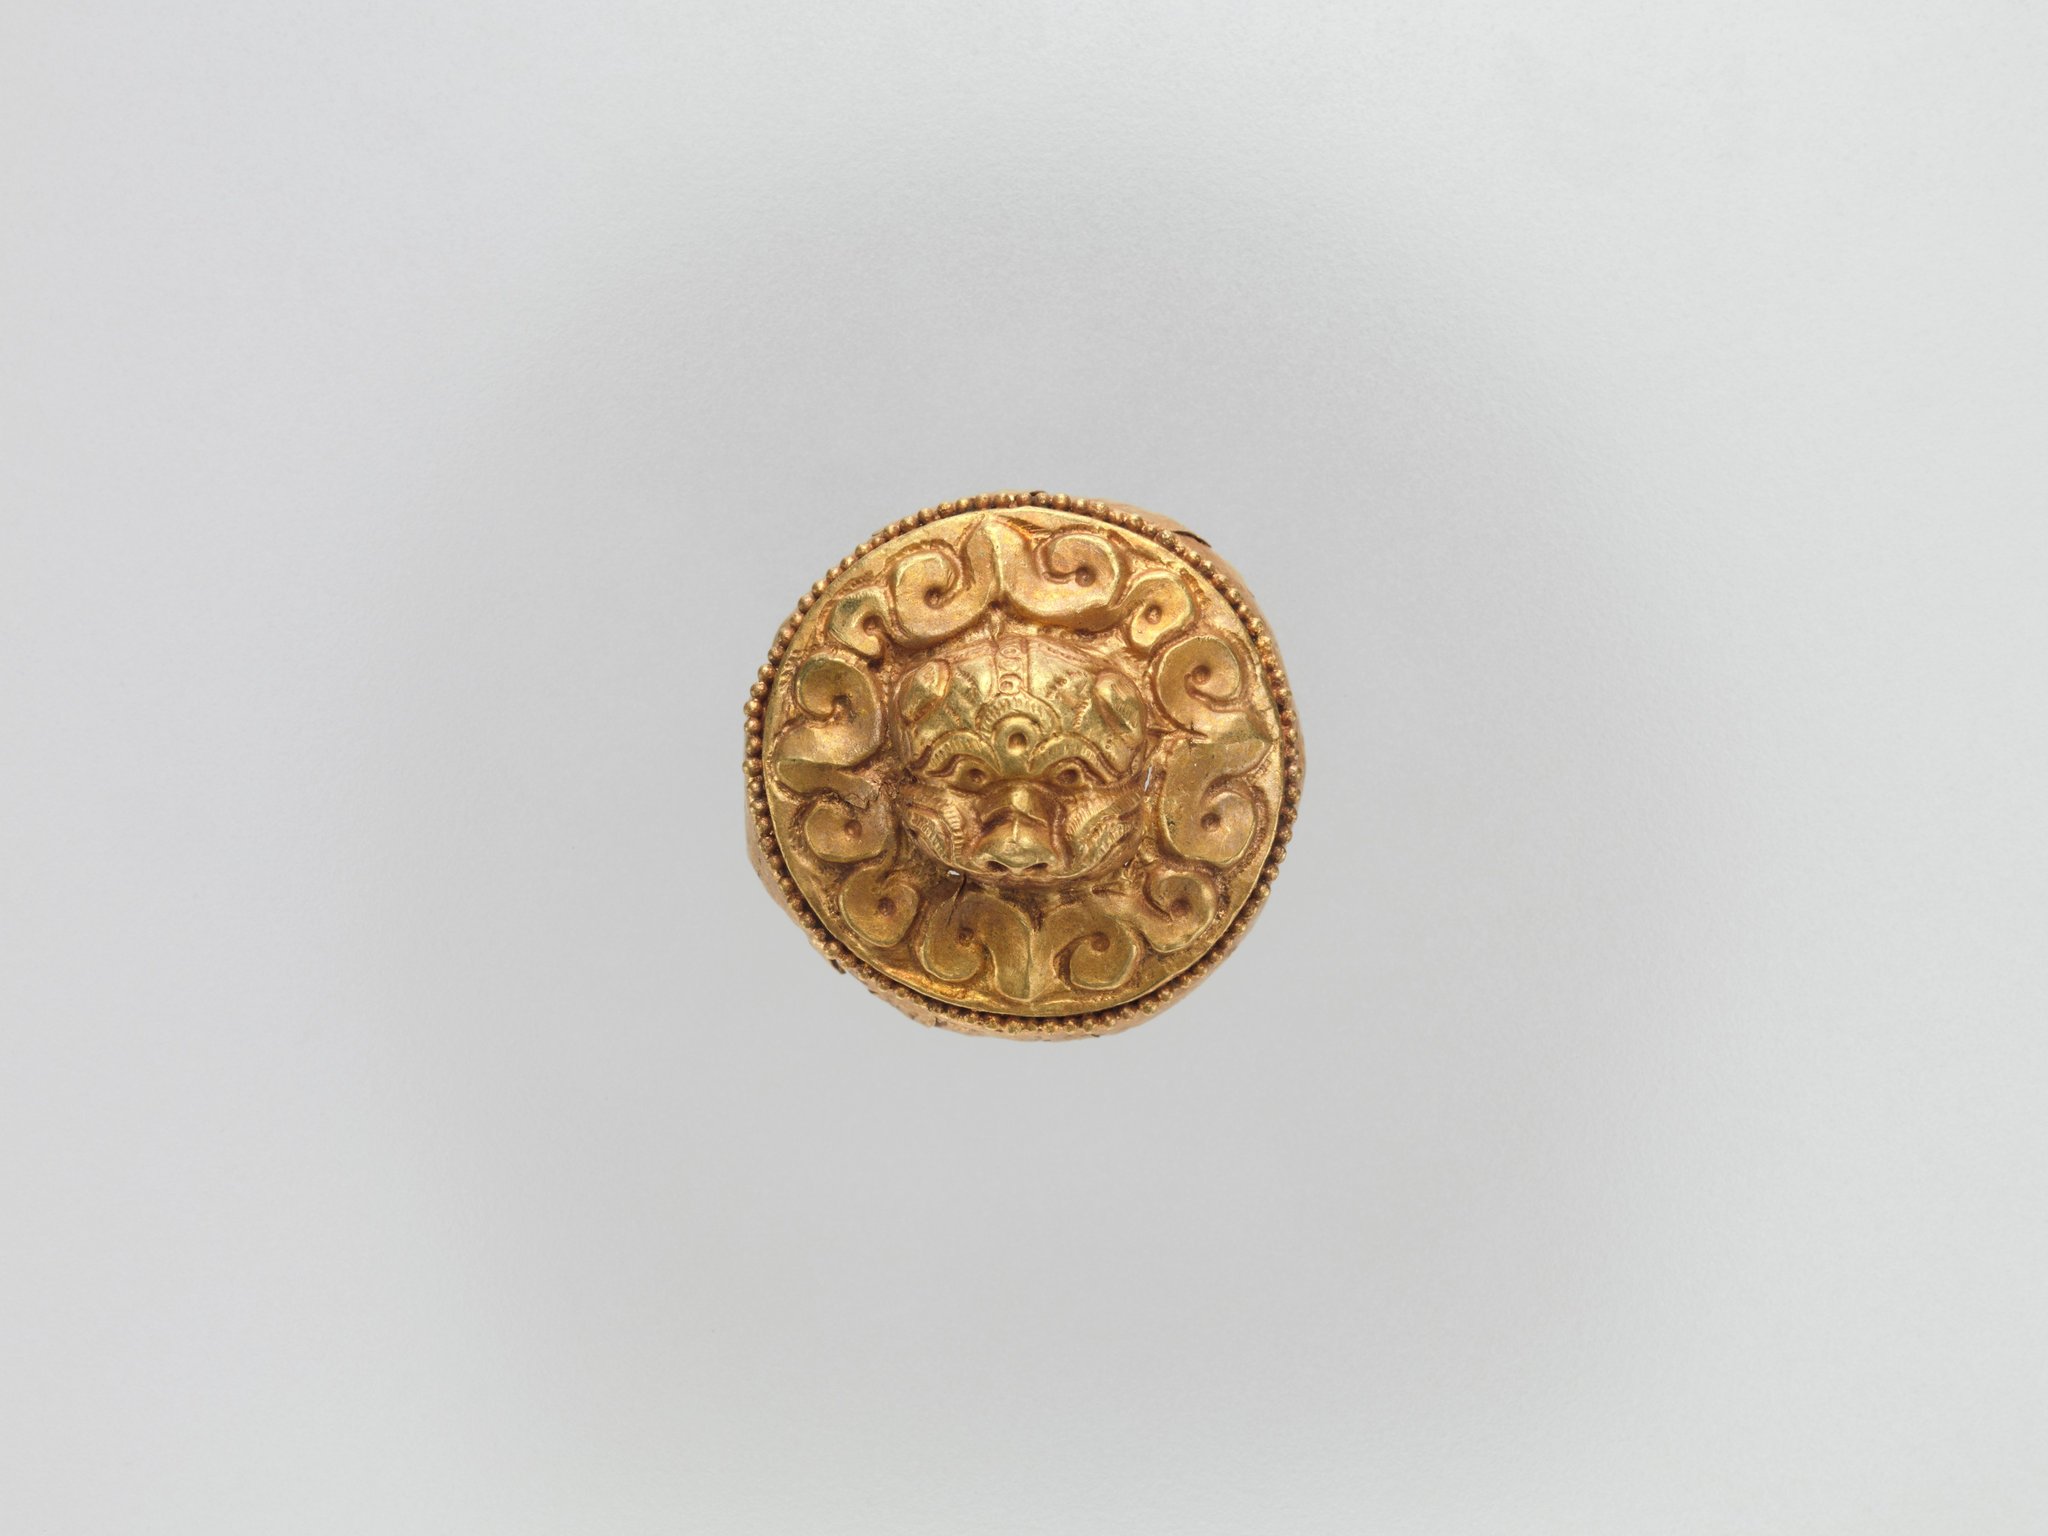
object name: plaque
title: Cap-Shaped Plaque with Lion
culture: chinese or central asian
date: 601-900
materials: gold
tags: lions